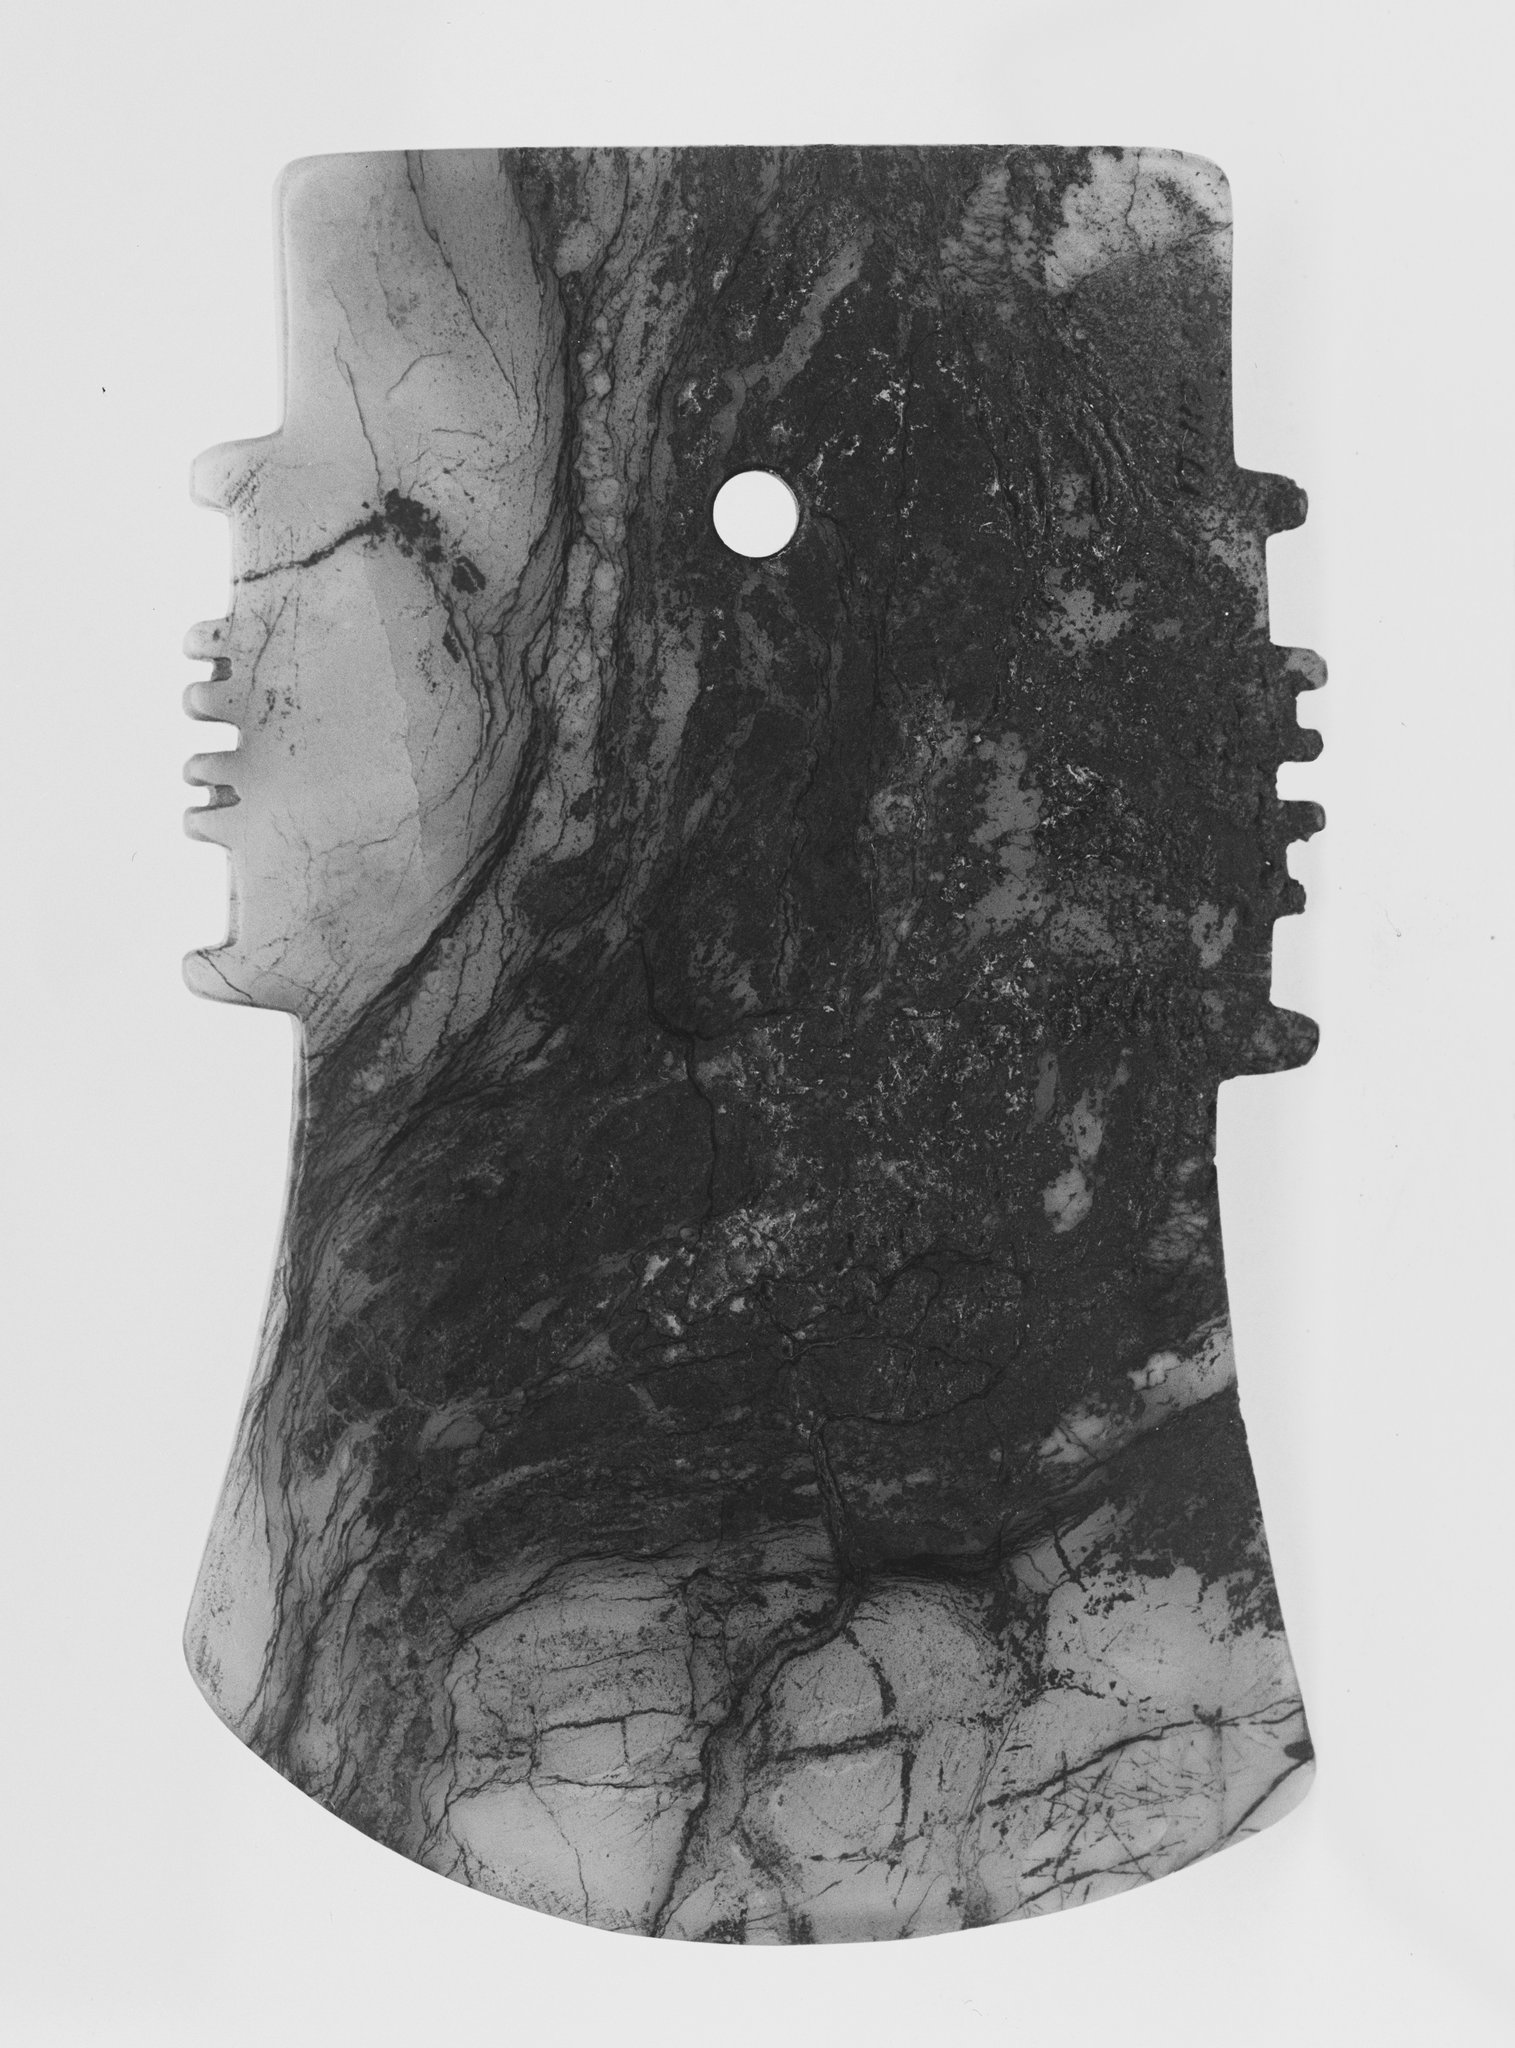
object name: ceremonial ax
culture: chinese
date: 1300-1001 BCE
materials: jade